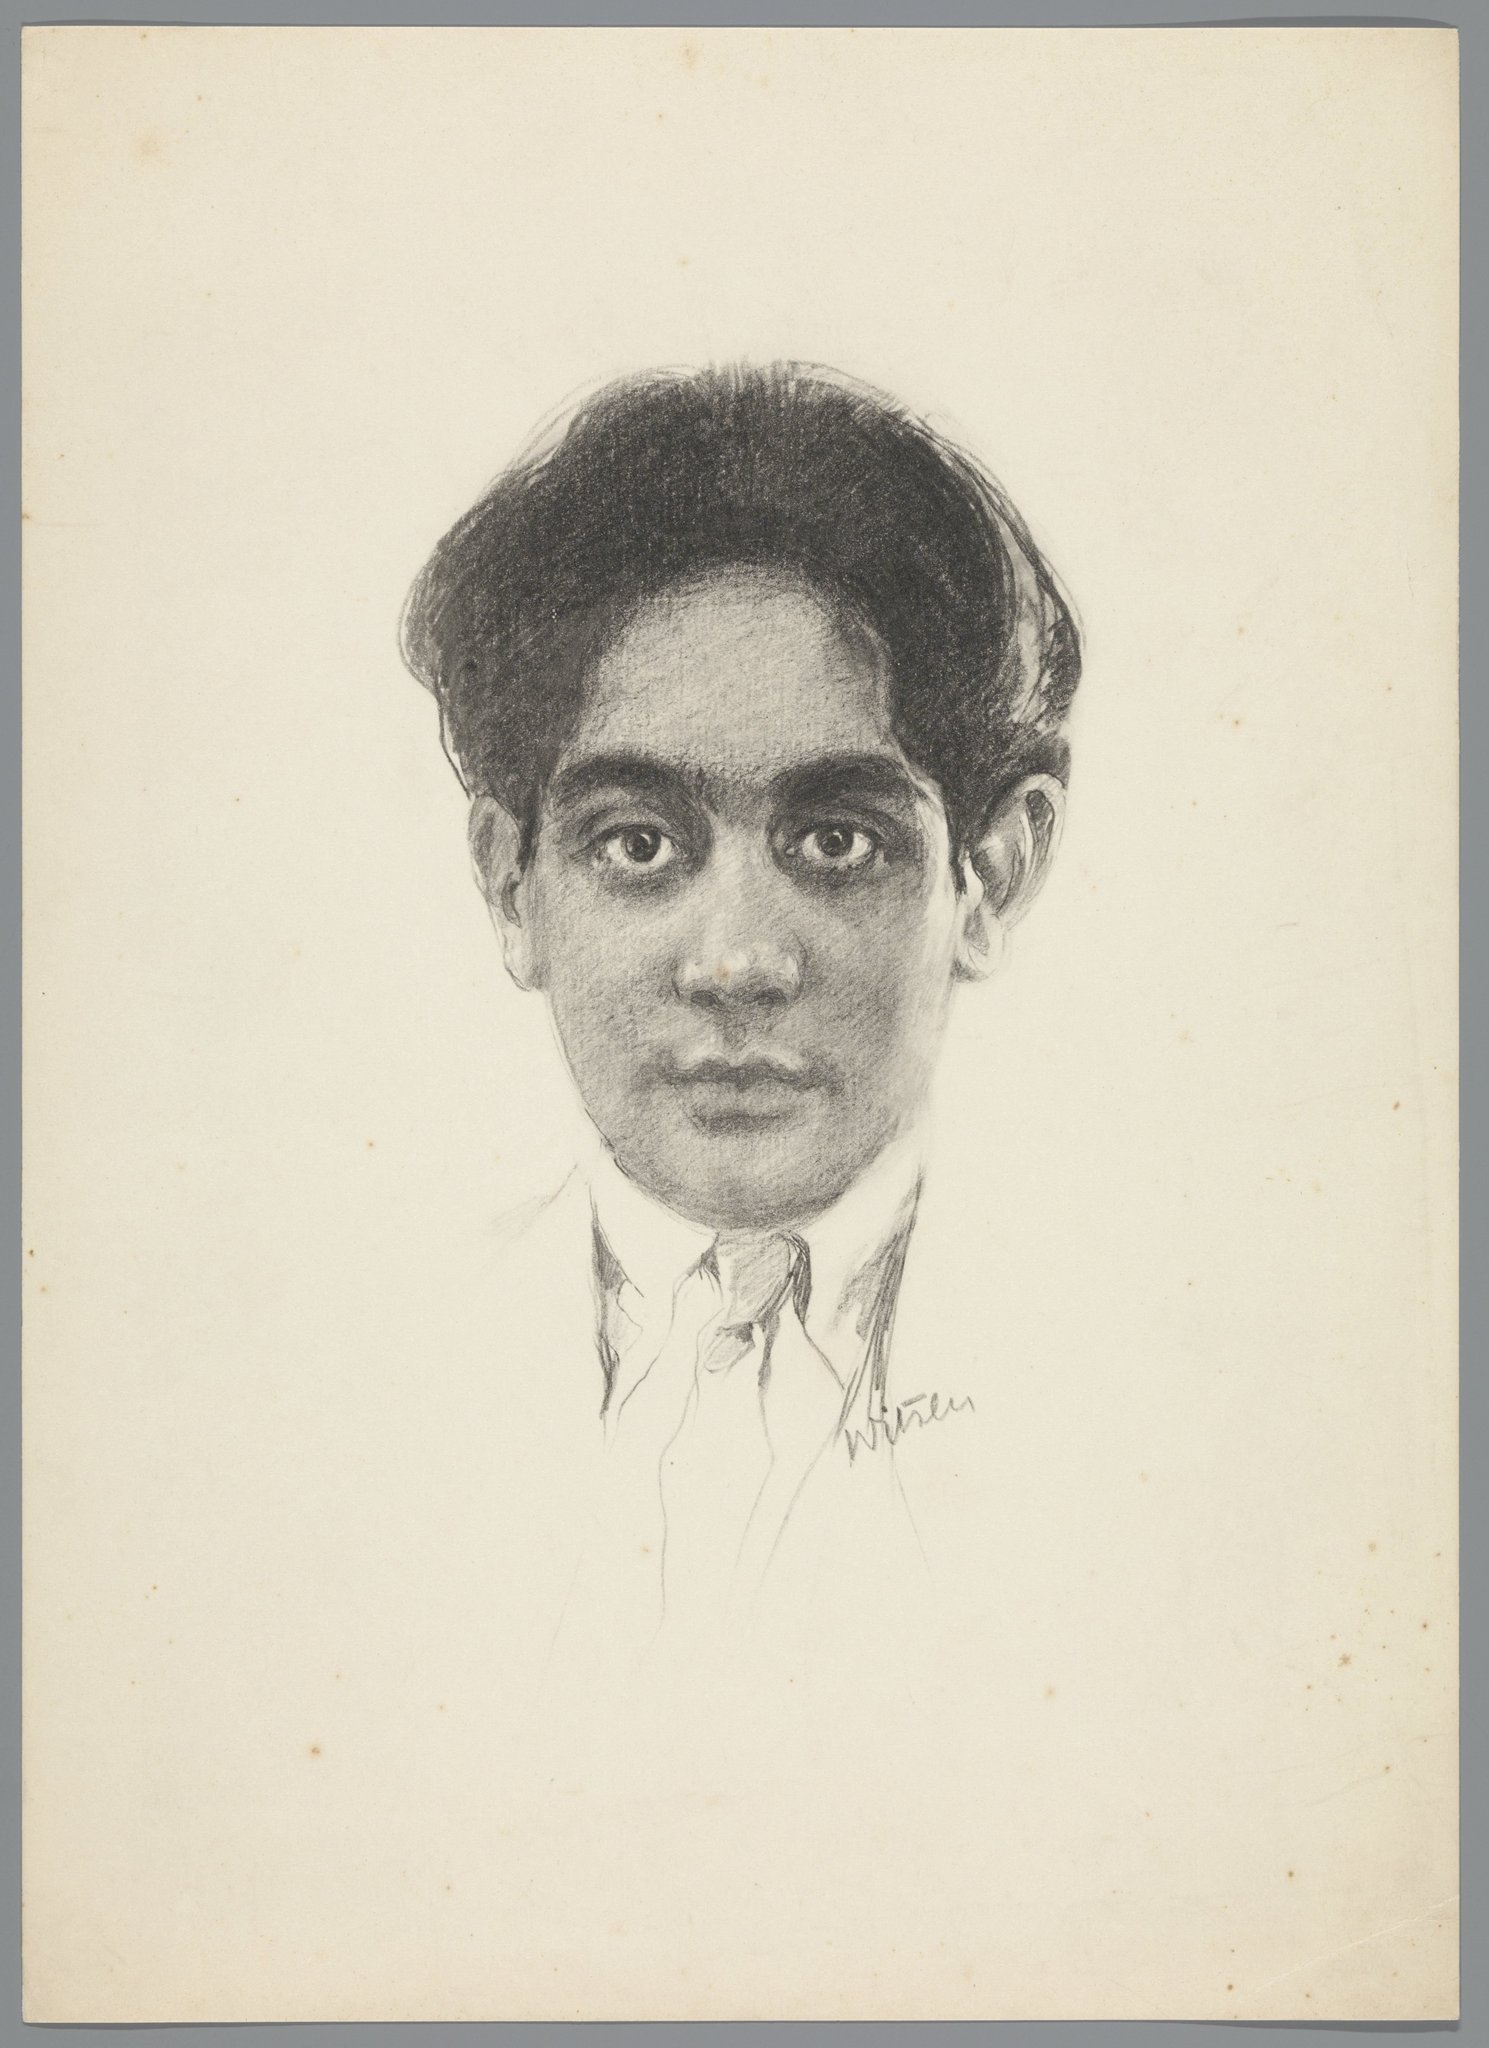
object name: reproduction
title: Reproductie van tekening met portret van Karamjit Singh Sahib Bahadur, prins van Kapurthala, door Willem Witsen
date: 1915-1916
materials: paper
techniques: photograph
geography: netherlands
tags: politician, historical persons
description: Voor schilderij van de geportretteerde door Witsen, zie collectie Dordrechts Museum (bruikleen RCE).